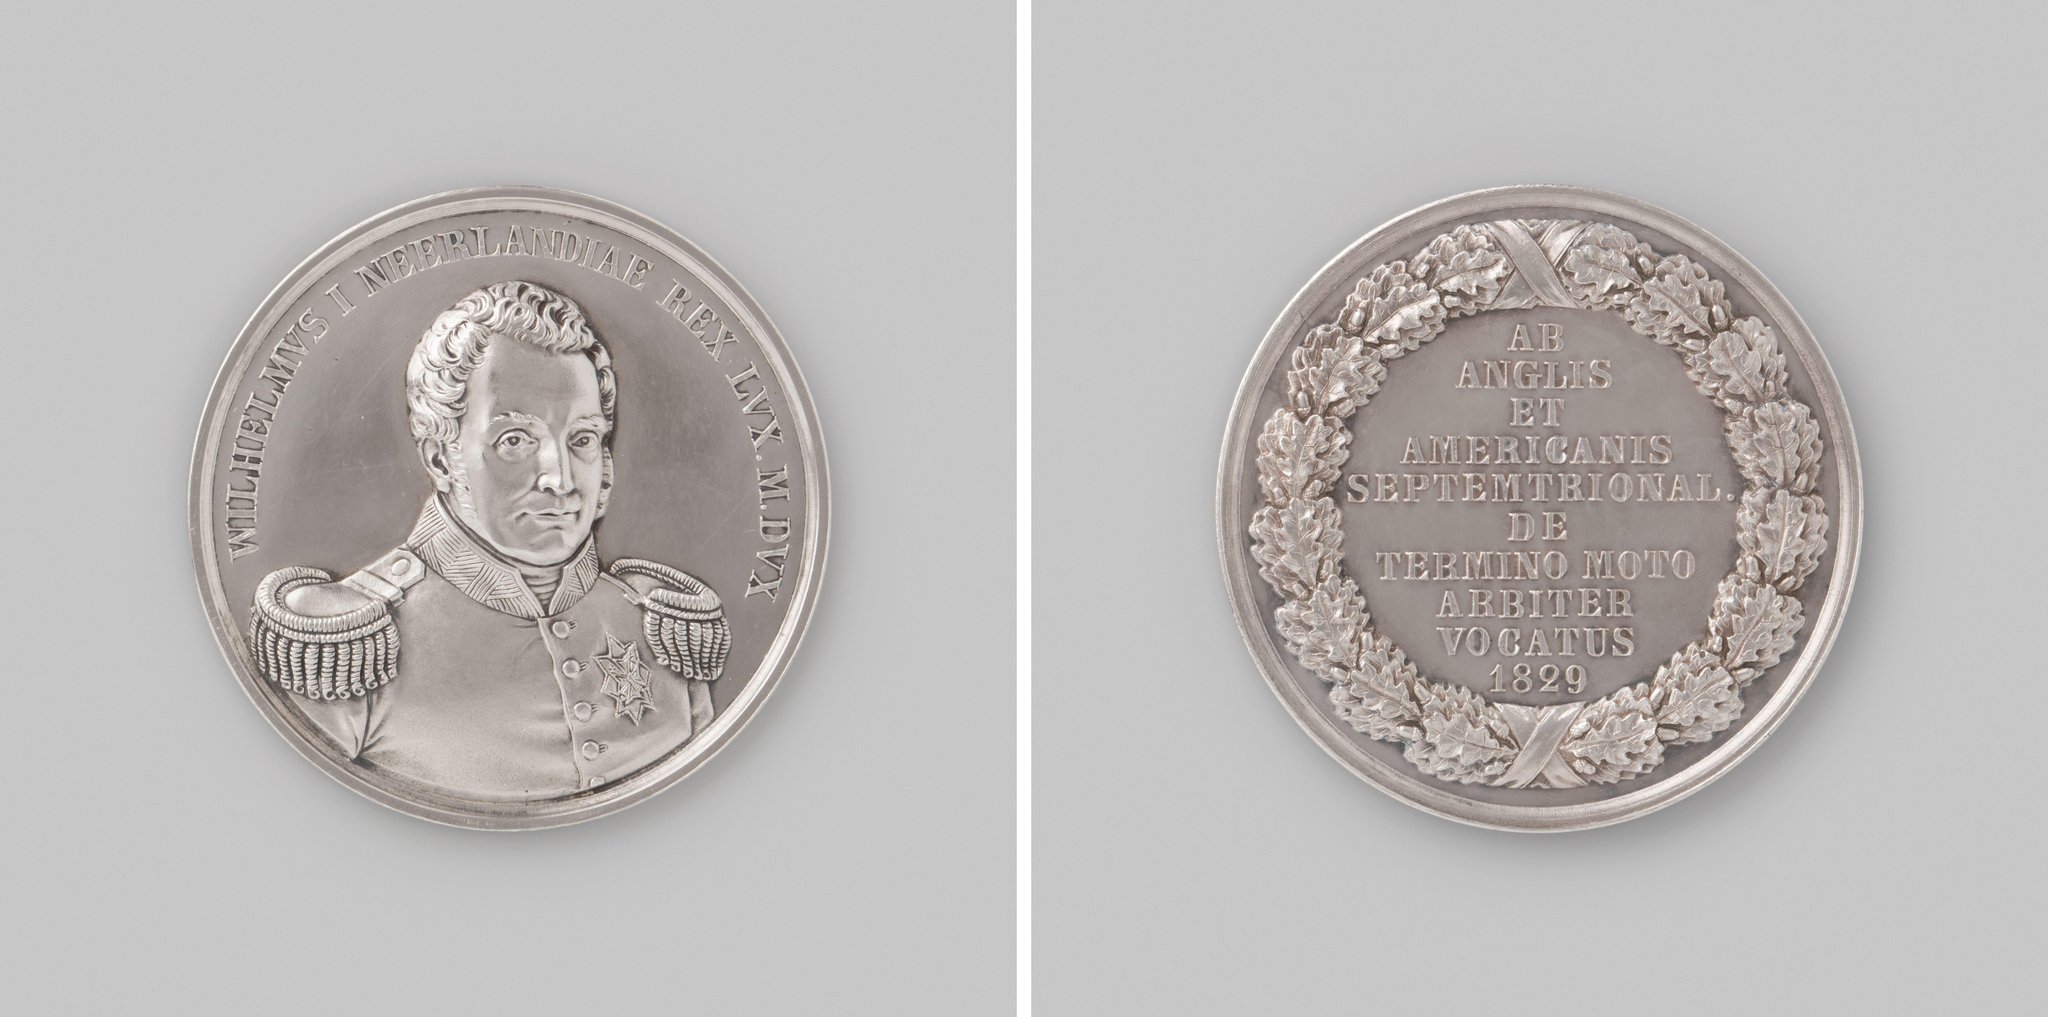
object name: history medal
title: Willem I Frederik, koning der Nederlanden, door Engelsen en Amerikanen tot scheidsrechter gekozen in een geschil over grensscheidingen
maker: pieter otto van der chijs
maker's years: 1802-1867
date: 1829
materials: silver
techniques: striking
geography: netherlands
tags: william i of the netherlands, united states of america, england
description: Zilveren penning. Voorzijde: borststuk man binnen omschrift. Keerzijde: opschrift binnen eikekrans